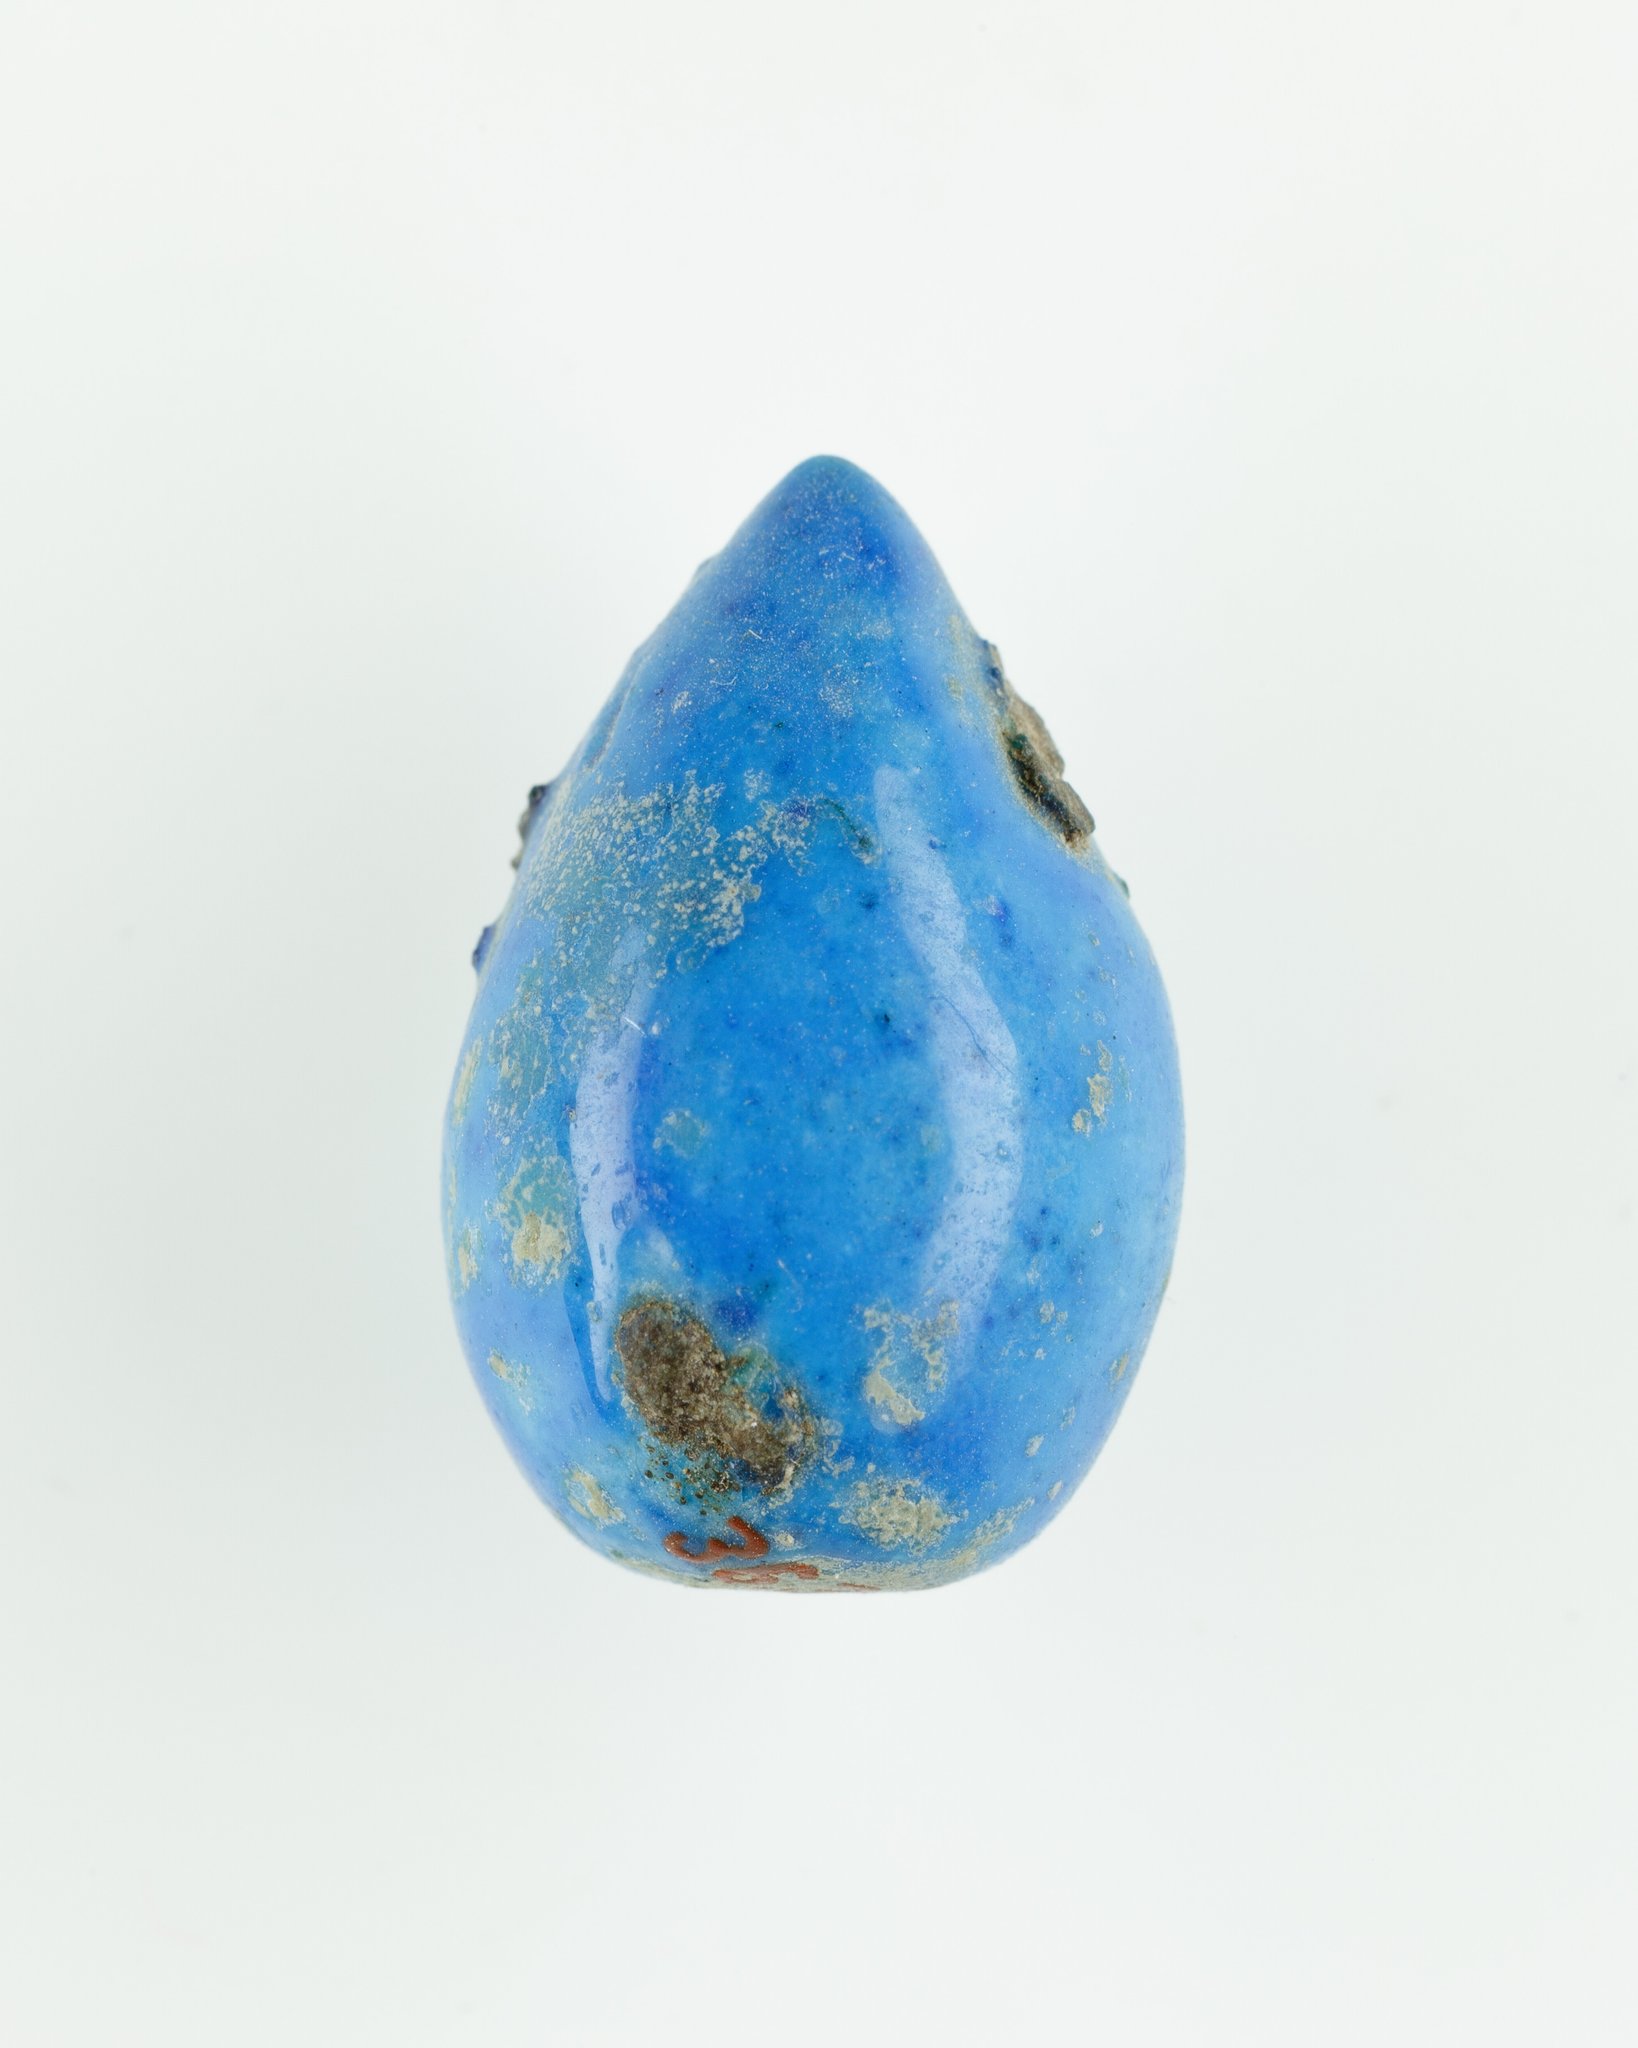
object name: amulet, persea fruit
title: Amulet in the Shape of a Persea Fruit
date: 1479-1458 BCE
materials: faience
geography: egypt